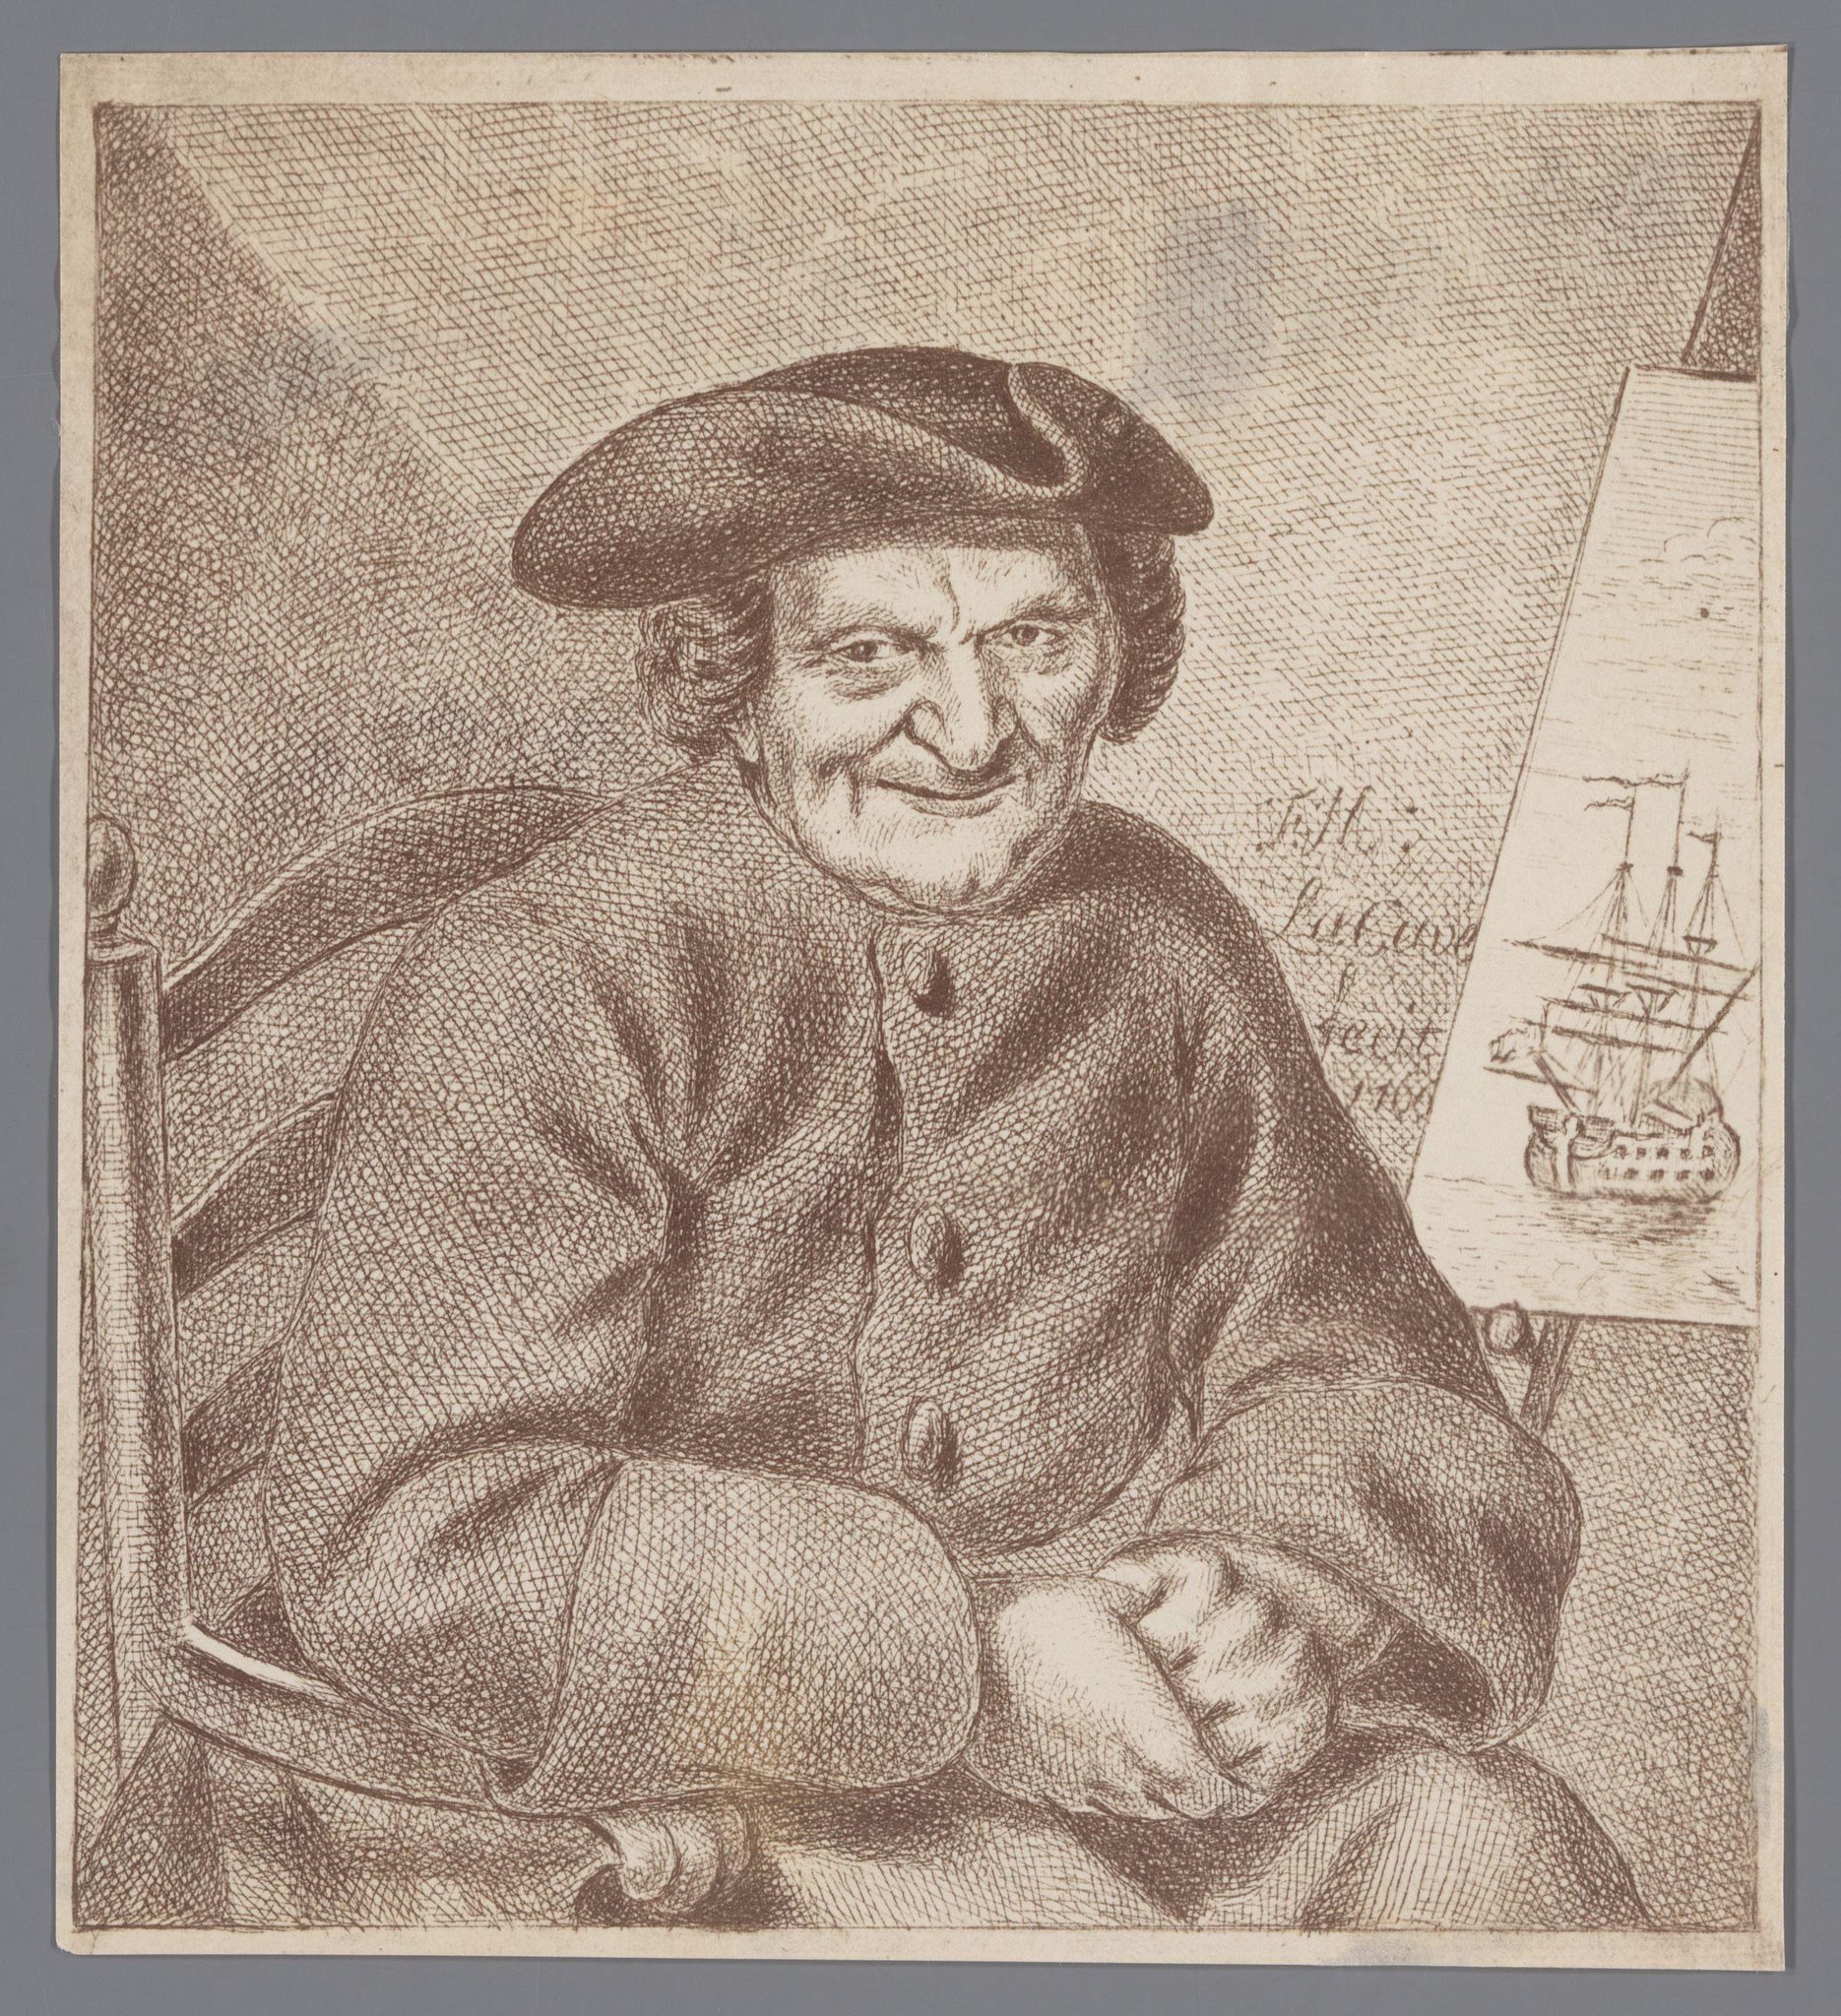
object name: photograph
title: Fotoreproductie van een geëtst portret van Adam Silo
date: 1851-1887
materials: paper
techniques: albumen print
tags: amsterdam, print maker, adam silo, portrait, self-portrait of painter, easel (+ paint ~ arts)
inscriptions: collector's mark: Lugt 2228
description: Adam Silo, schilder en prentmaker, zittend op een stoel. Naast hem een schildersezel met een schilderij van een schip op zee.